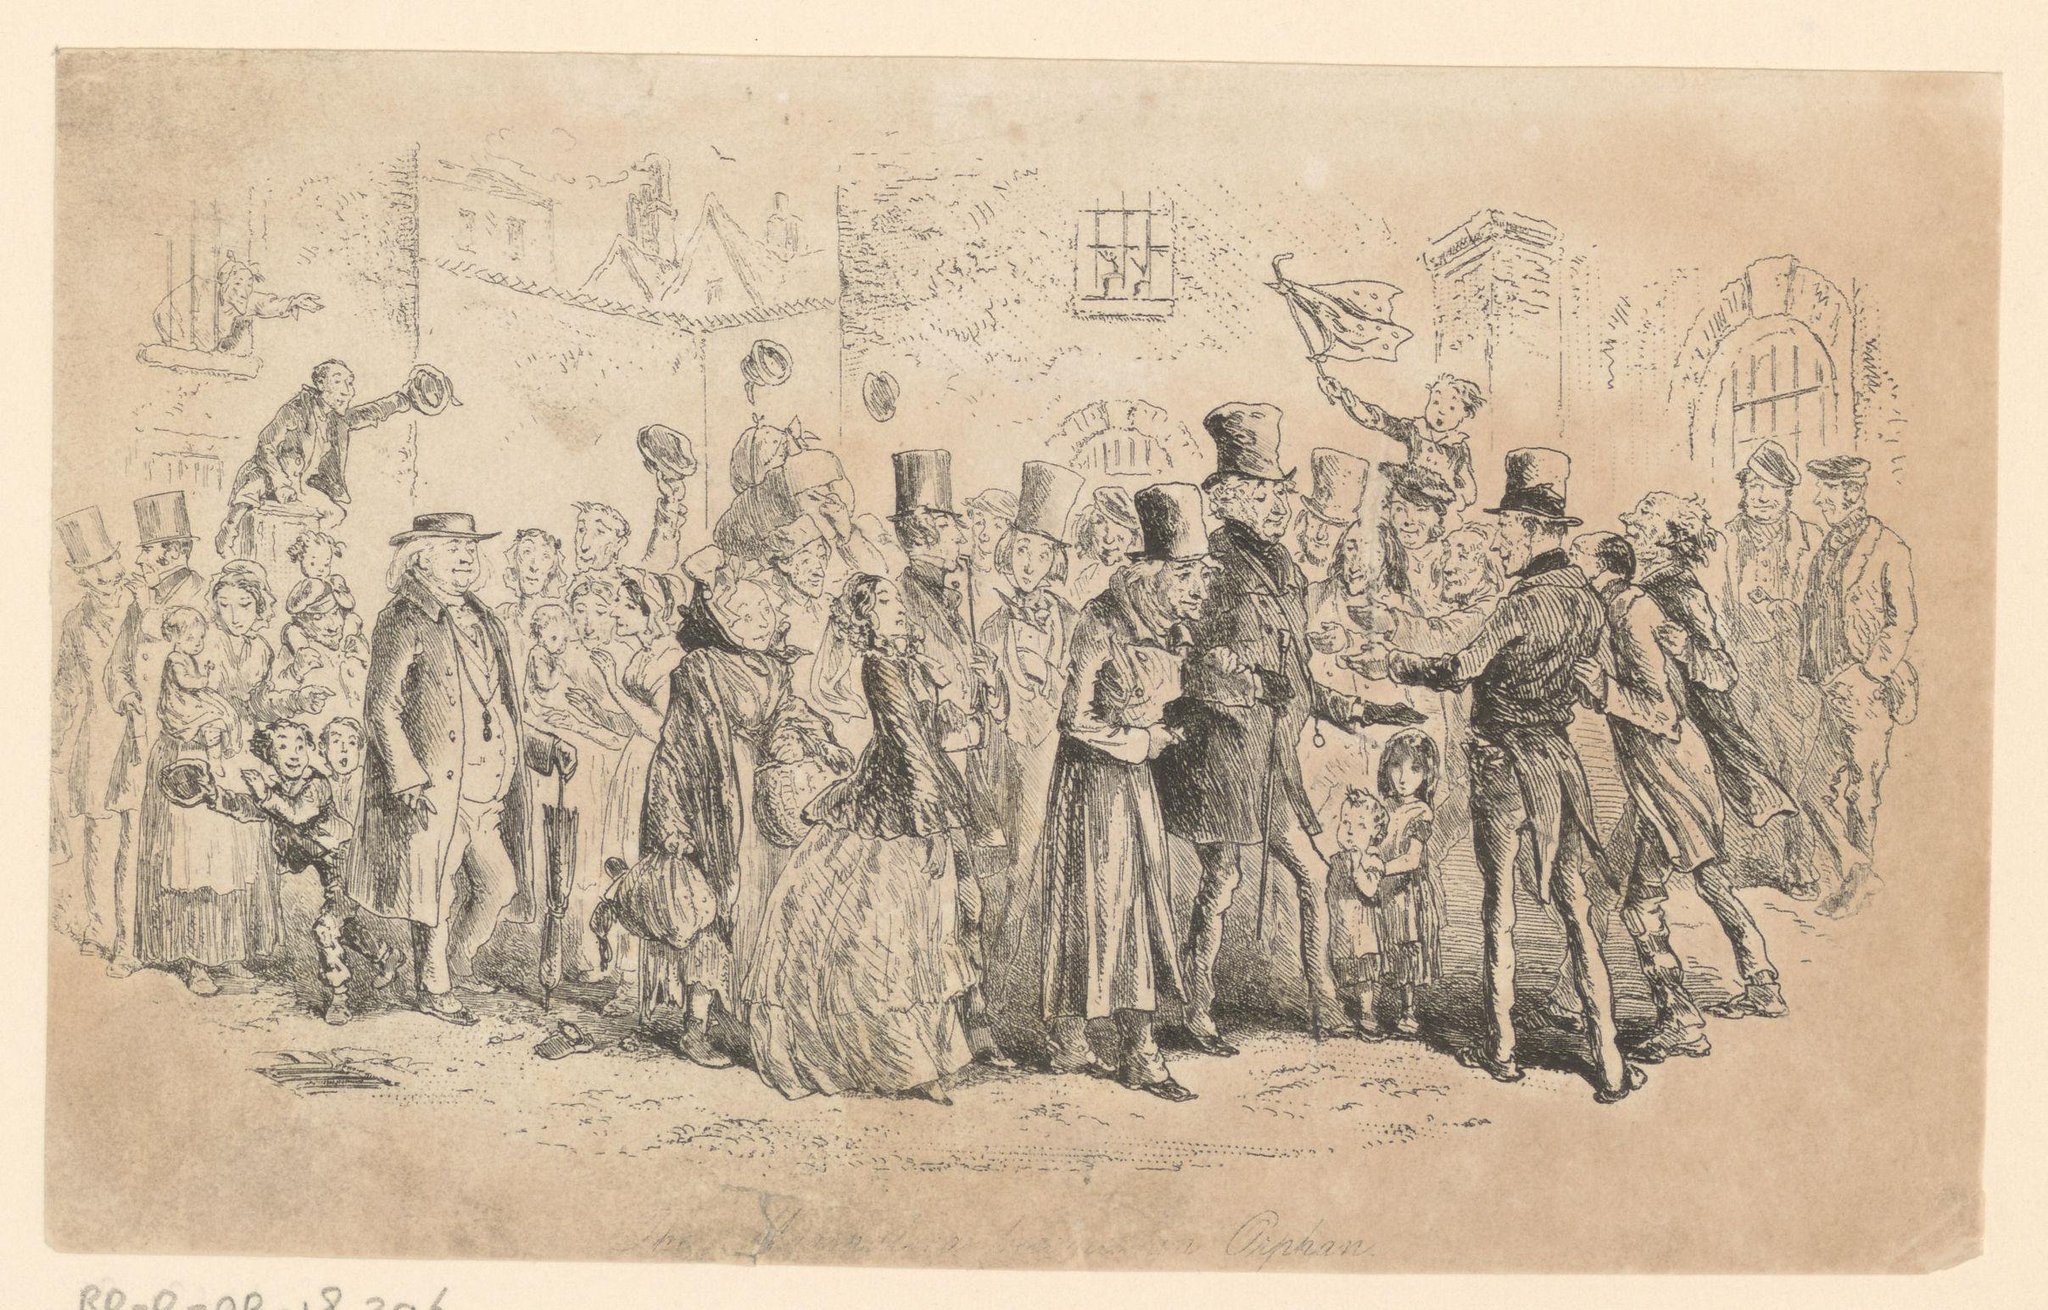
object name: print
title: Menigte buiten de gevangenis Marshalsea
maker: hablot knight browne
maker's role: print maker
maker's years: 1815-1882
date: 1810-1856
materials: paper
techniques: etching, roulette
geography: london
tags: prison, jail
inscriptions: collector's mark: Lugt 2228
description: Prent uit: Dickens, Charles. Little Dorrit. Londen: Bradbury & Evans, 1857. Het boek werd tussen 1855 en 1857 eerst in delen uitgegeven. Deze prent werd uitgegeven in oktober 1856.